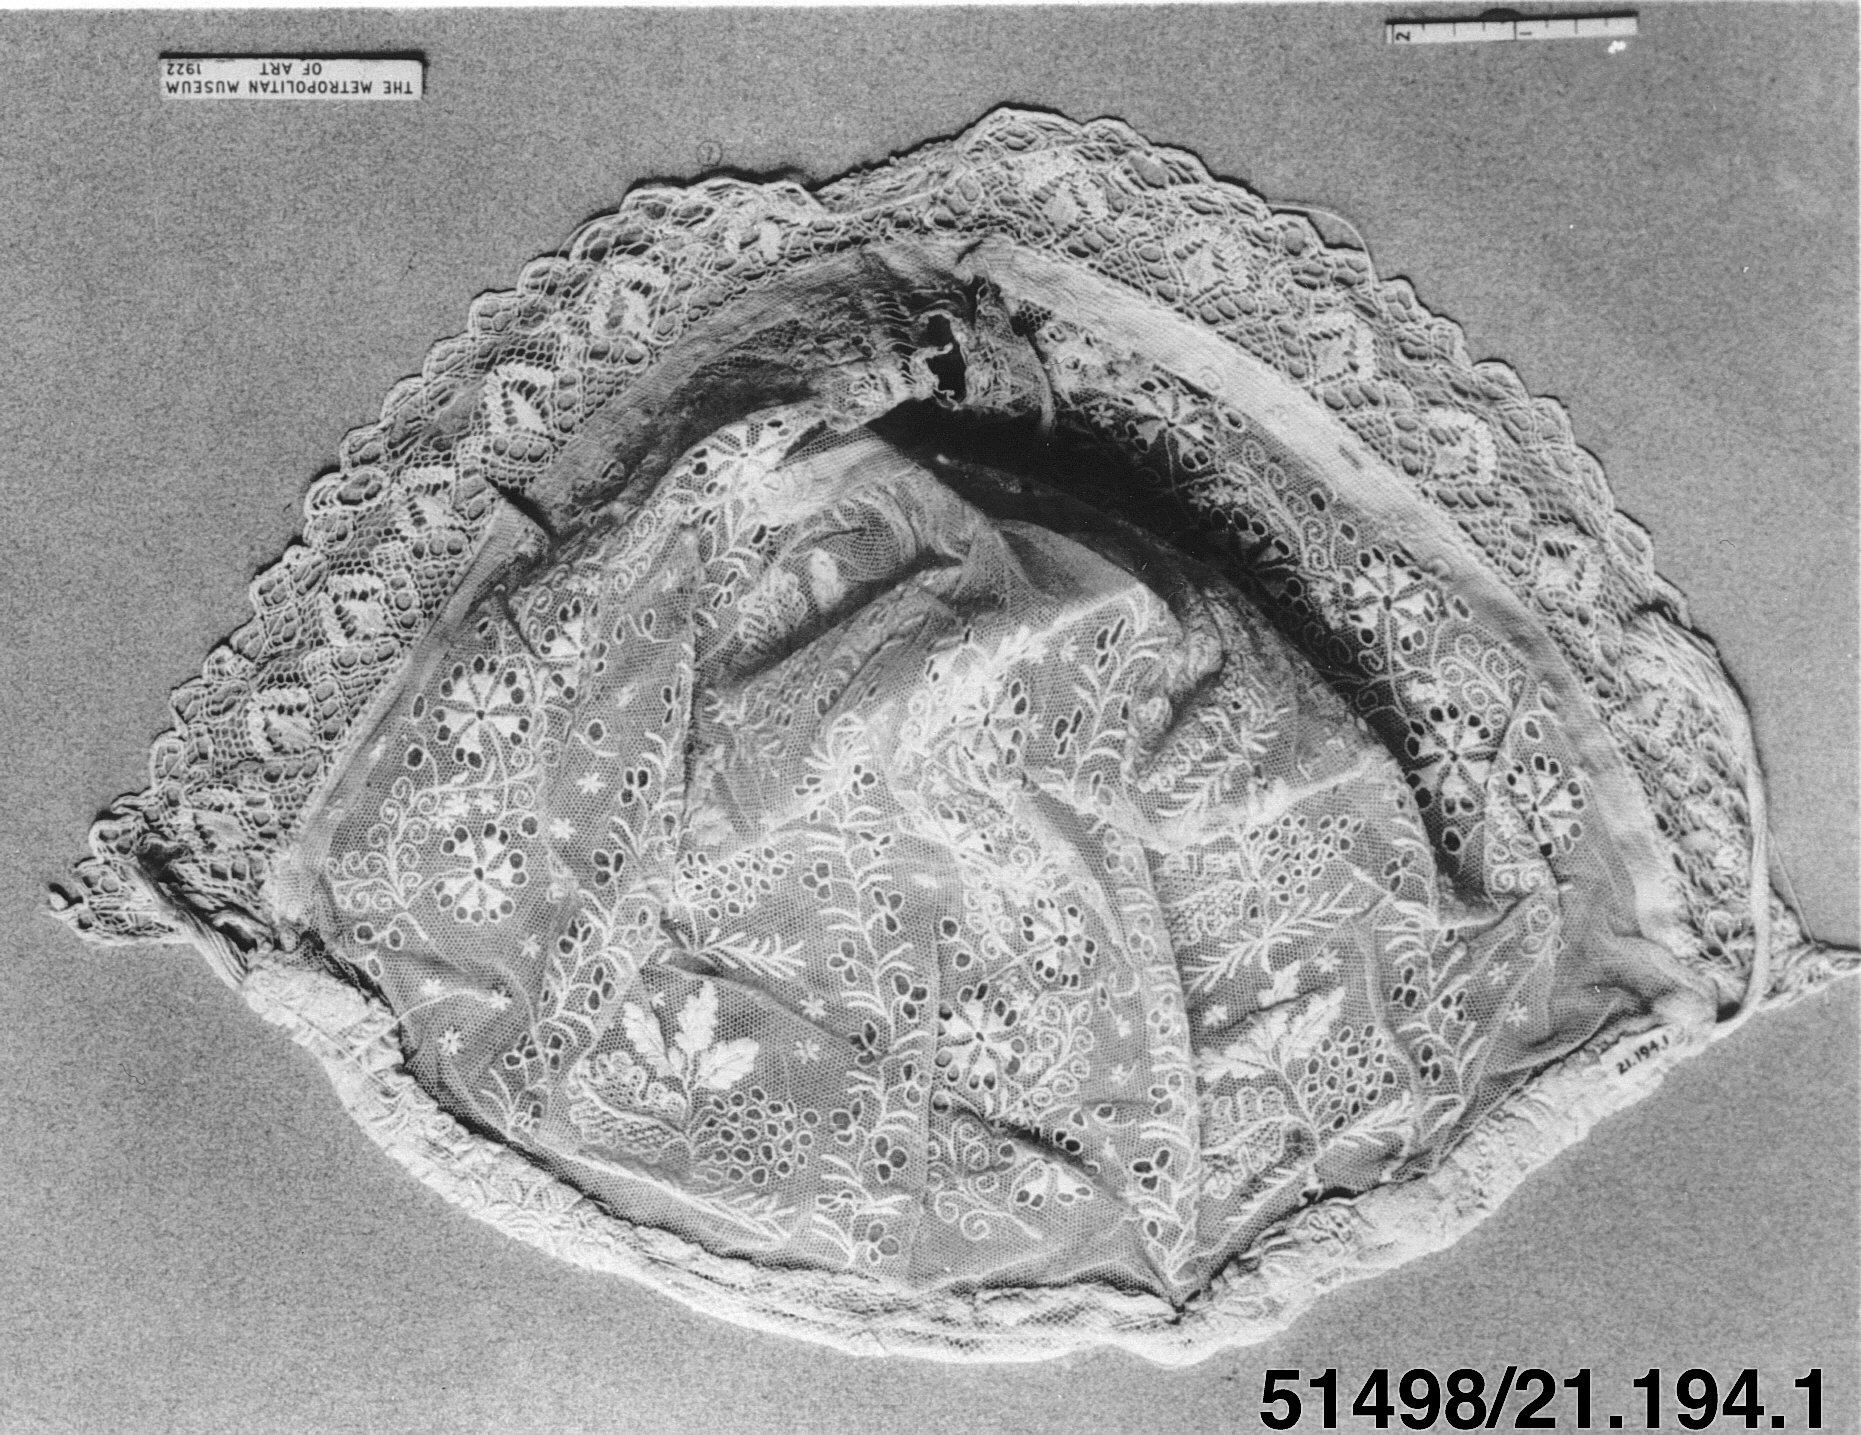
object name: cap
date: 1801-1900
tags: flowers